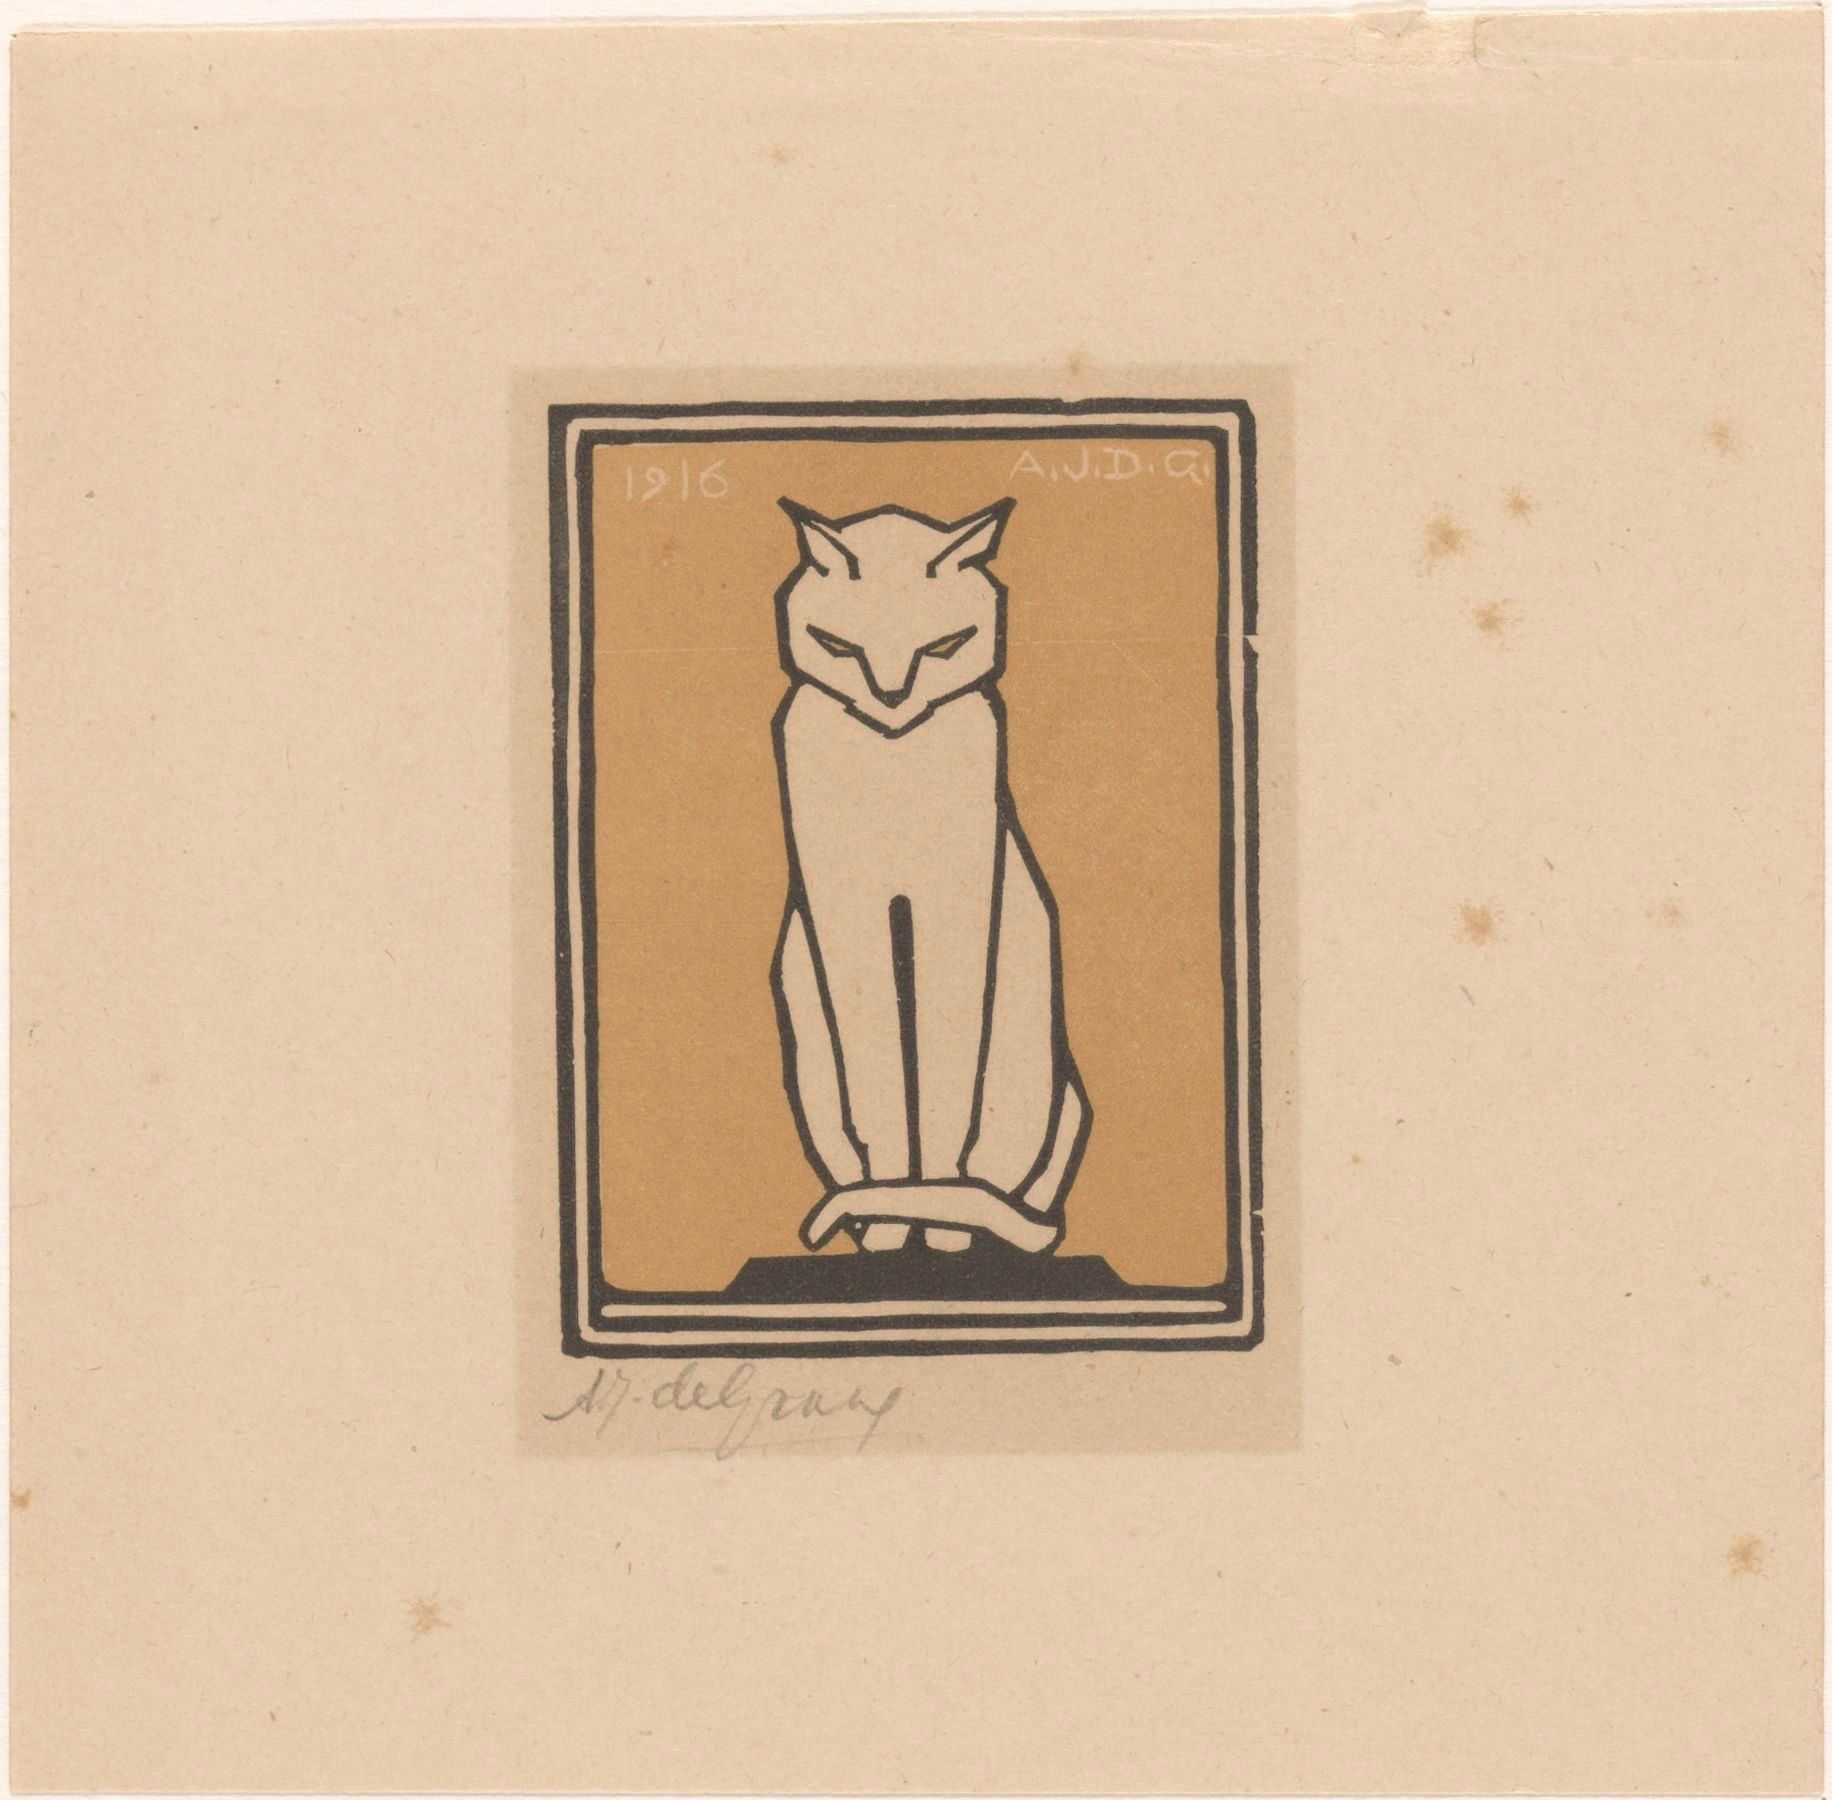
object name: print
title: Zittende kat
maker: julie de graag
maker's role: draughtsman, print maker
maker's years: 1877-1924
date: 1916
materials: paper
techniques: woodcut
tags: cat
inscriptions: collector's mark: Lugt 2228